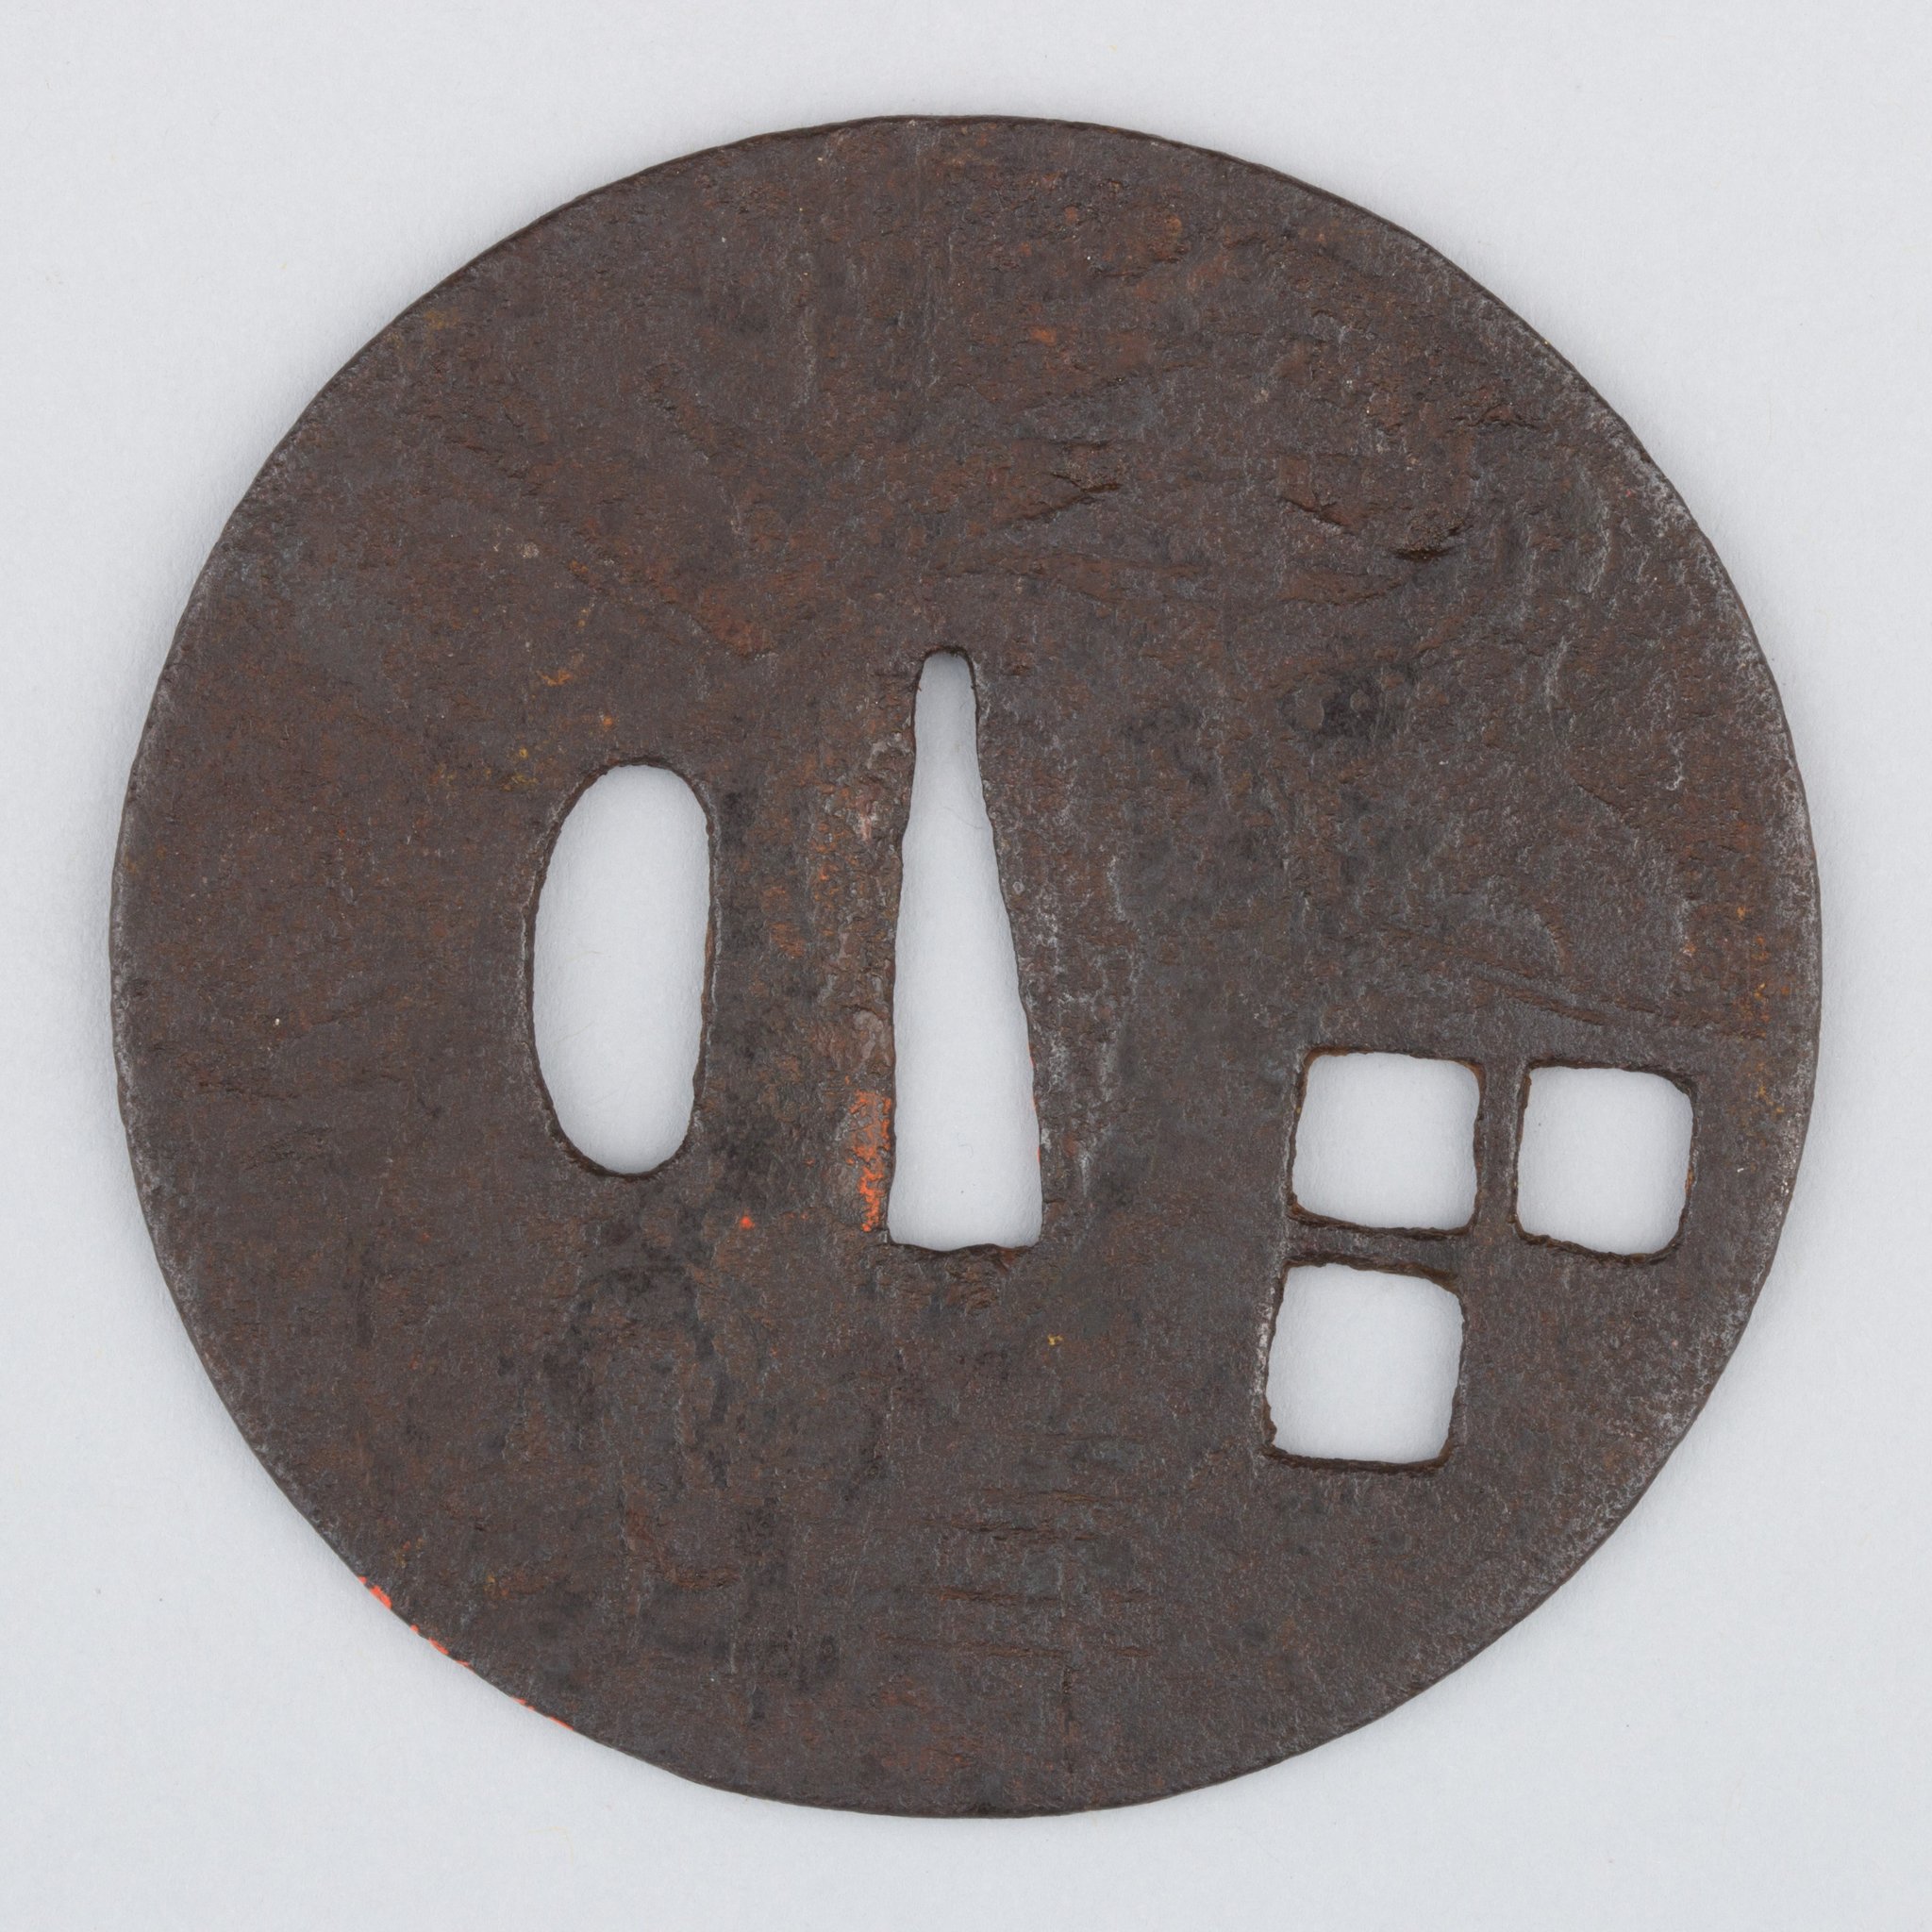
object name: sword guard tsuba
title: Sword Guard (Tsuba)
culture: japanese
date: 1615-1868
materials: copper, iron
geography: japan